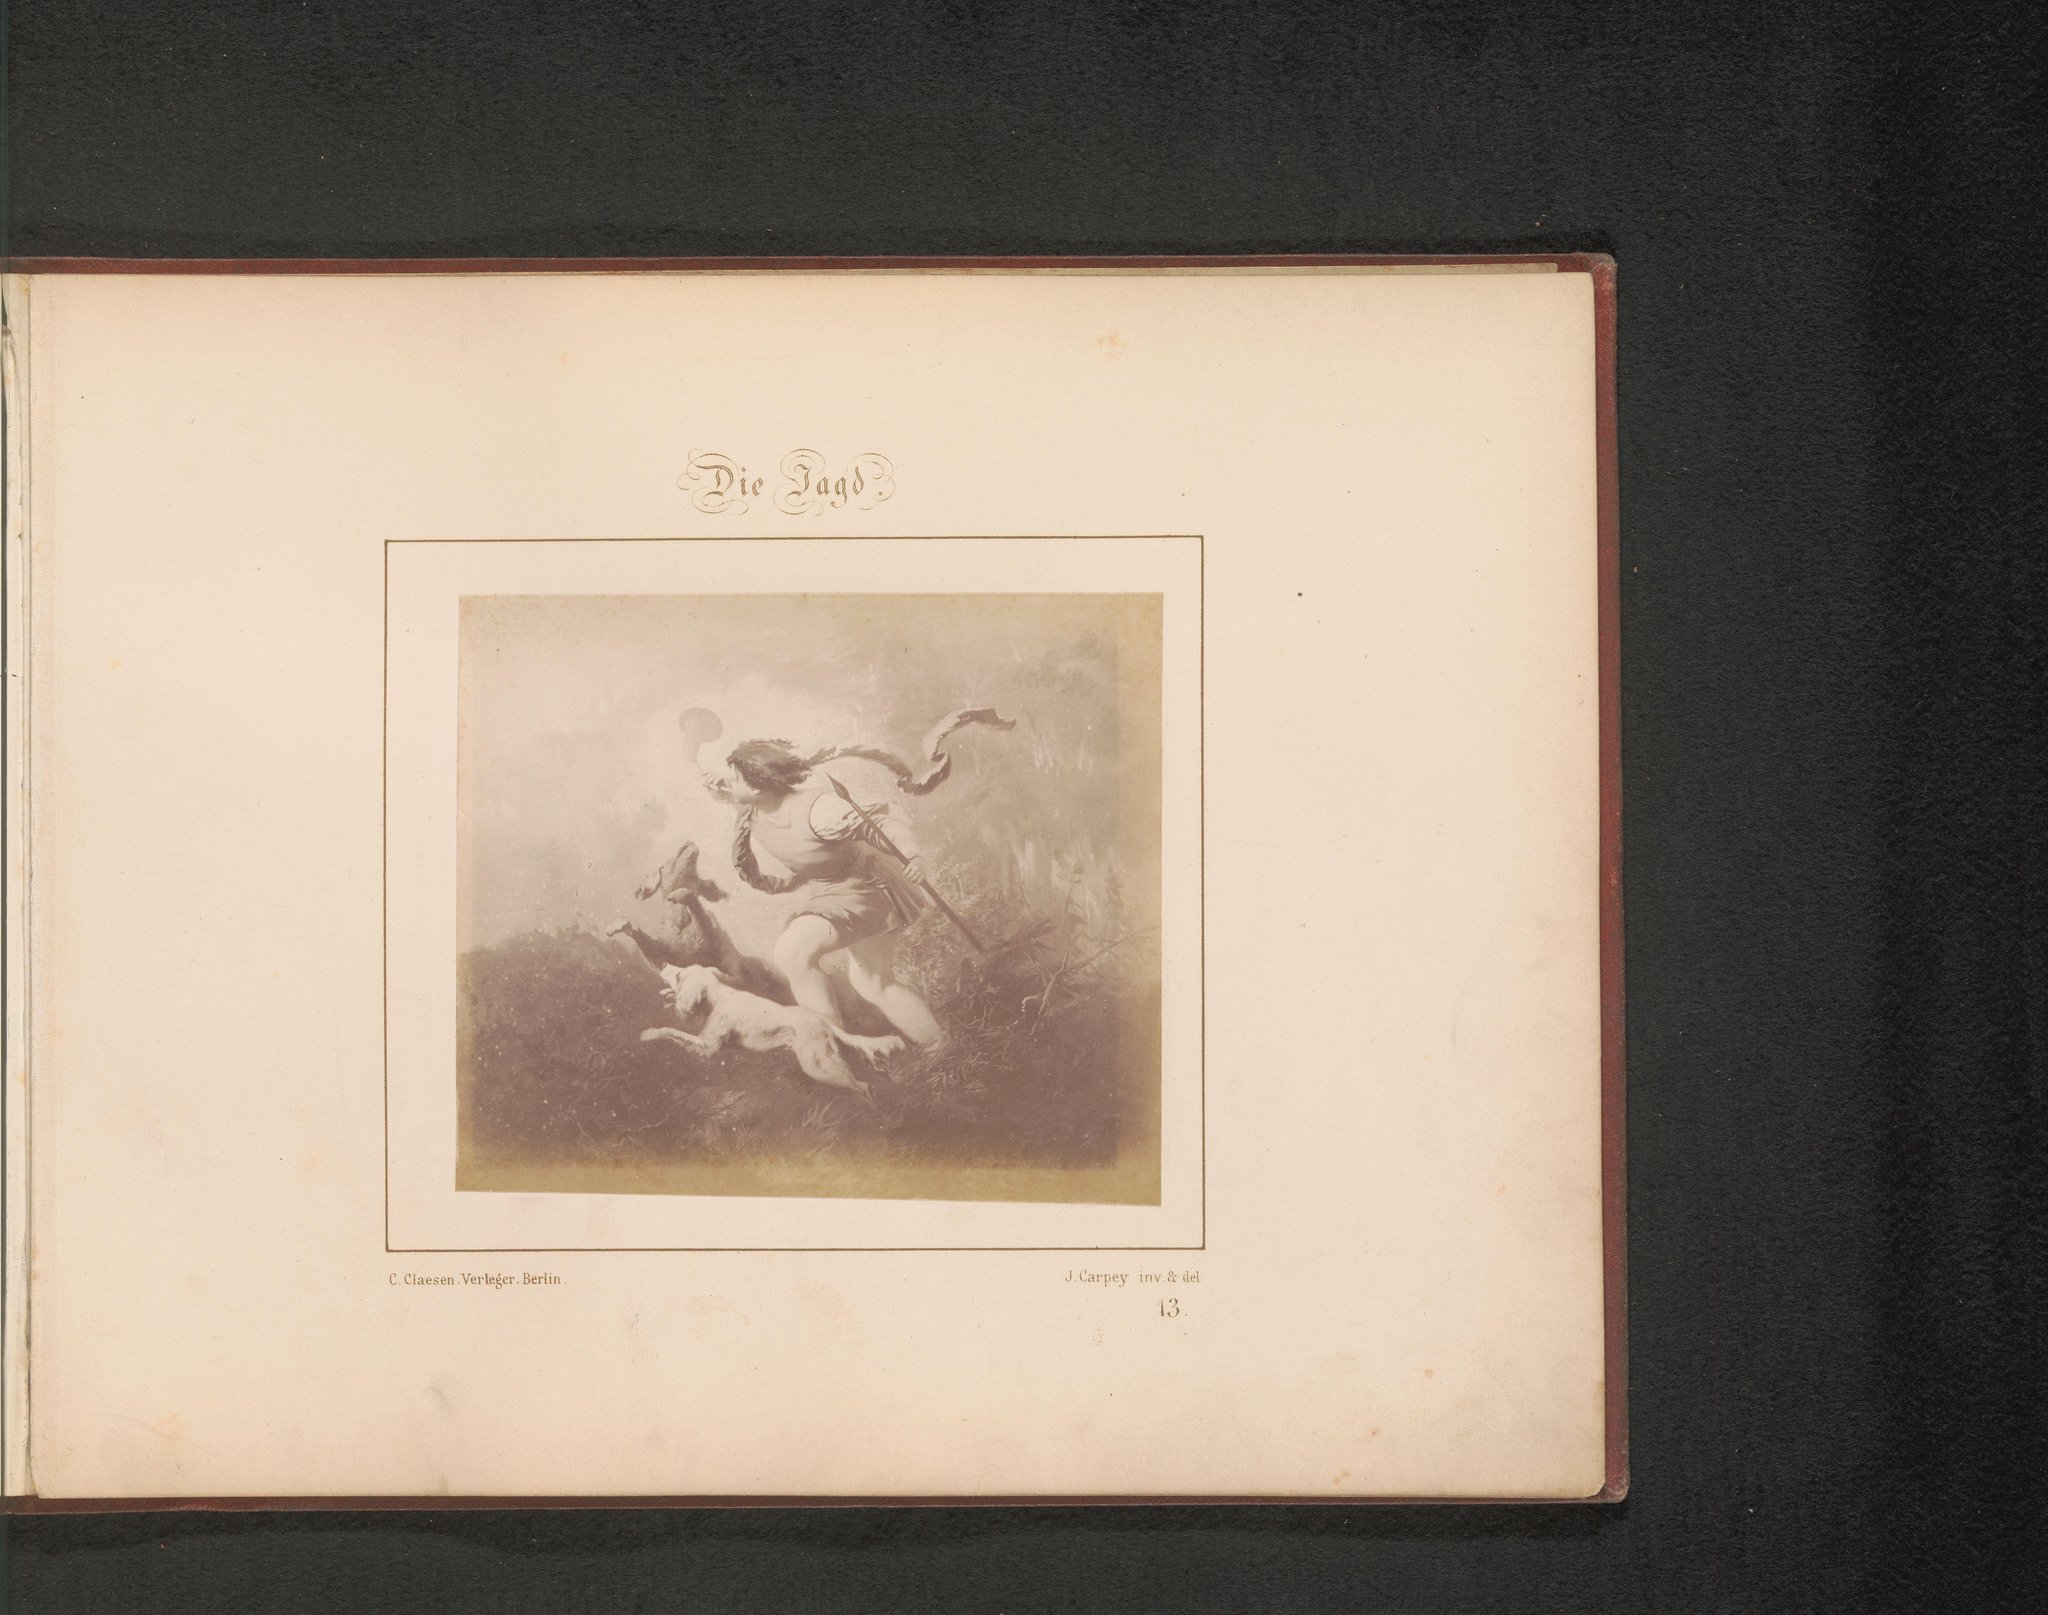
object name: page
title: Die Jagd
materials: photographic support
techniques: albumen print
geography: berlin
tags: hunting dogs, hunting, chase (+ sportsman, player, etc. (sports ~ animals))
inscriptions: number: ‘13.’